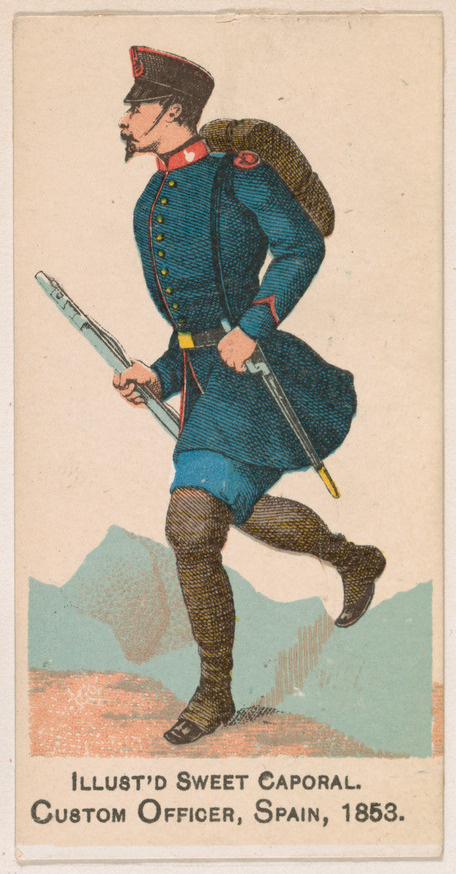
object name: print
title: Custom Officer, Spain, 1853, from the Military Series (N224) issued by Kinney Tobacco Company to promote Sweet Caporal Cigarettes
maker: kinney brothers tobacco company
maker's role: publisher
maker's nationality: american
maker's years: 1869-2011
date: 1888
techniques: color lithograph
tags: military,men,profiles